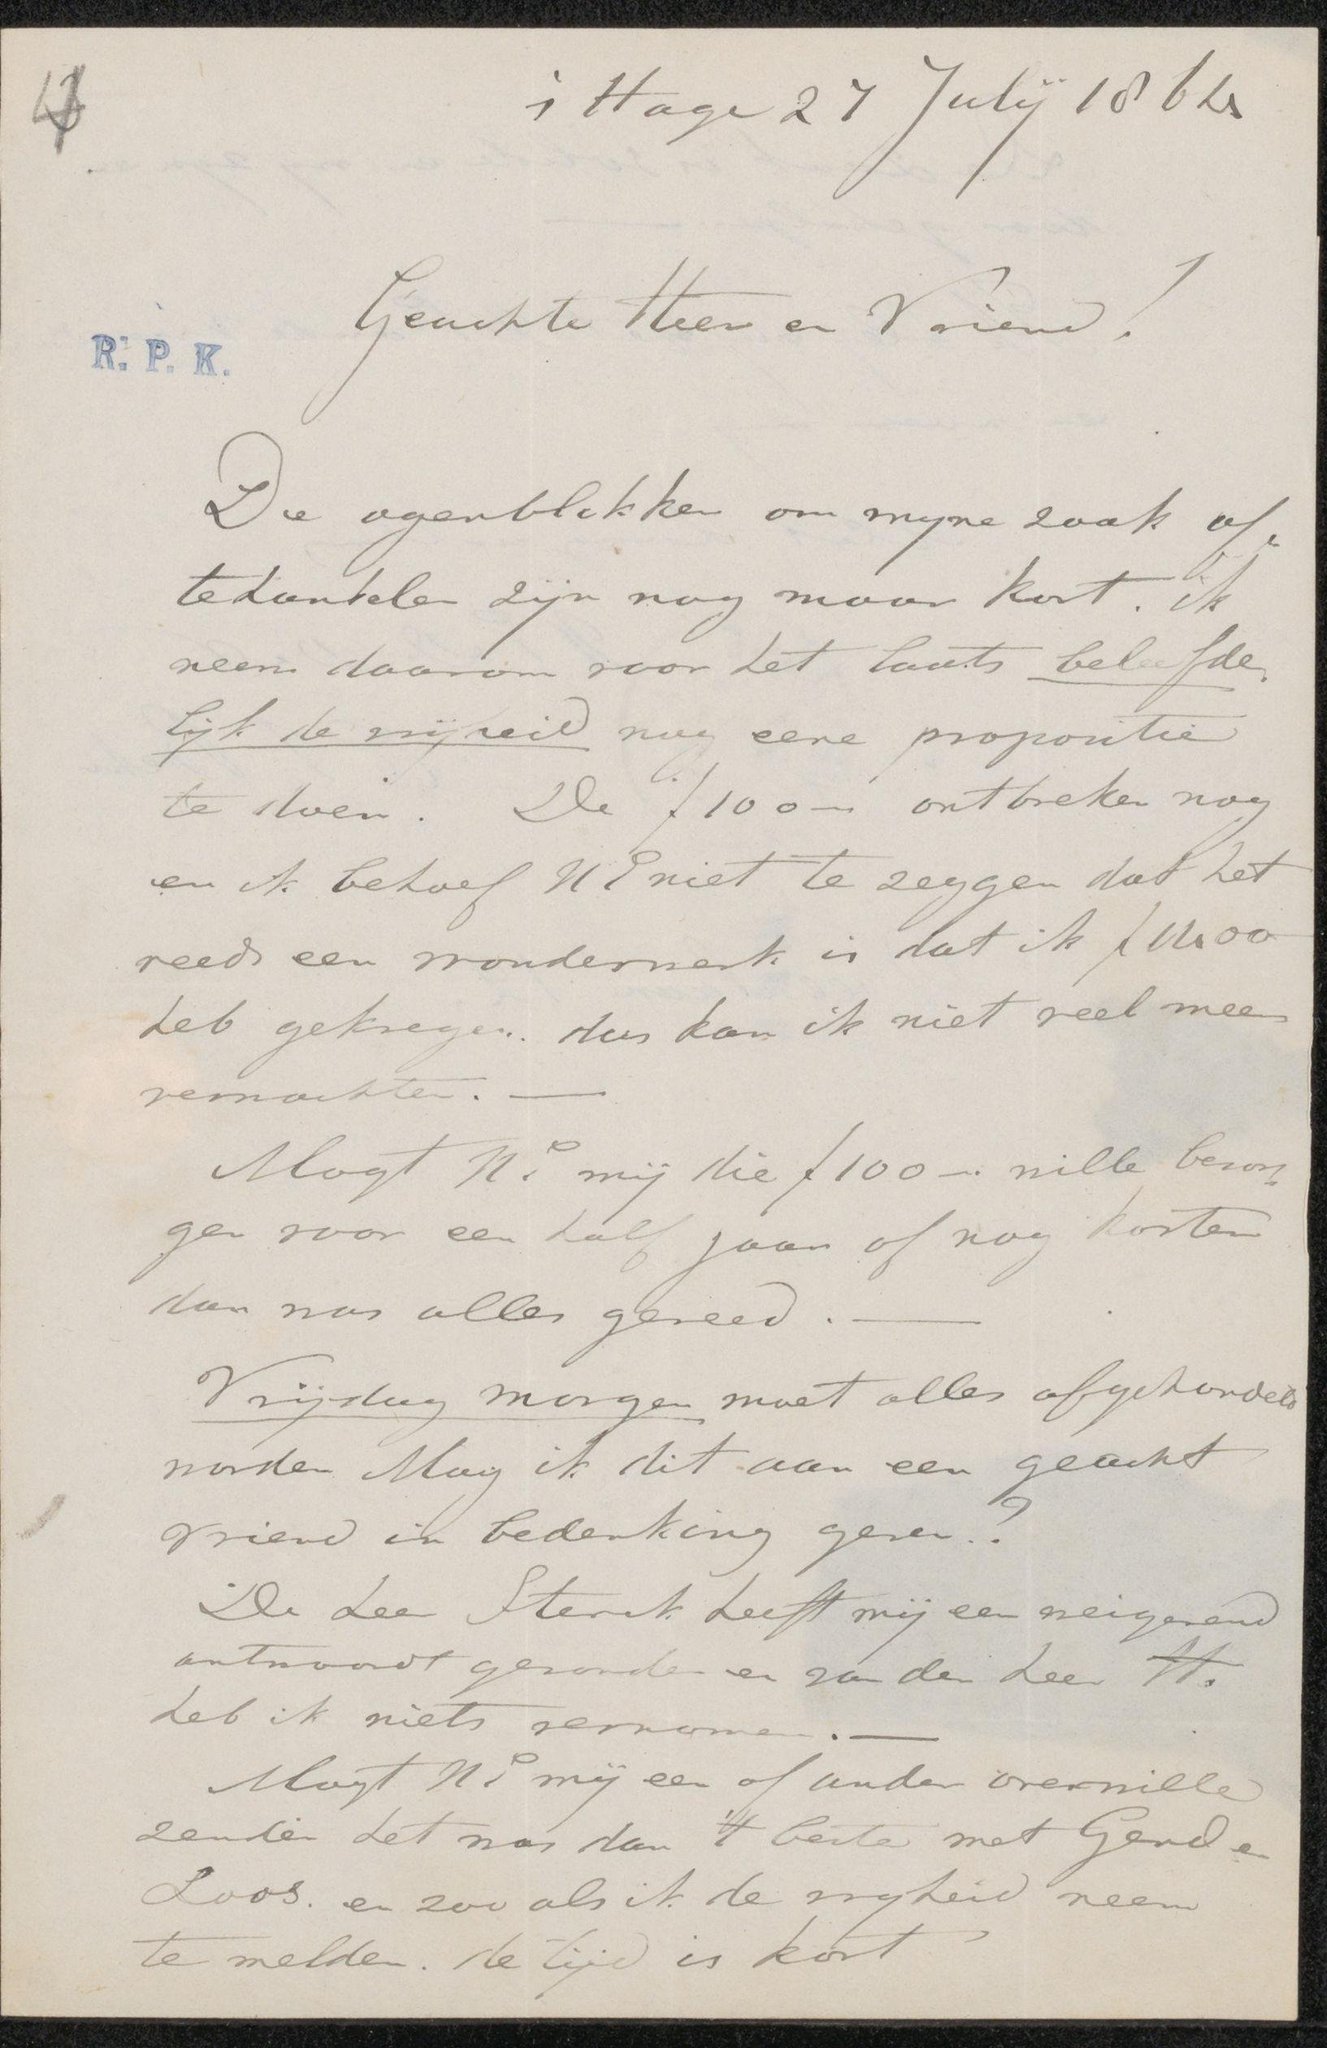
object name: letter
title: Brief aan Alberto Caramelli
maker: carel jacobus behr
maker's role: draughtsman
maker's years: 1812-1895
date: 1864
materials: ink, paper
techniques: pen, writing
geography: the hague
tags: utrecht, amsterdam, publisher, alberto caramelli, money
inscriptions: collector's mark: ‘RPK’ Lugt 2233